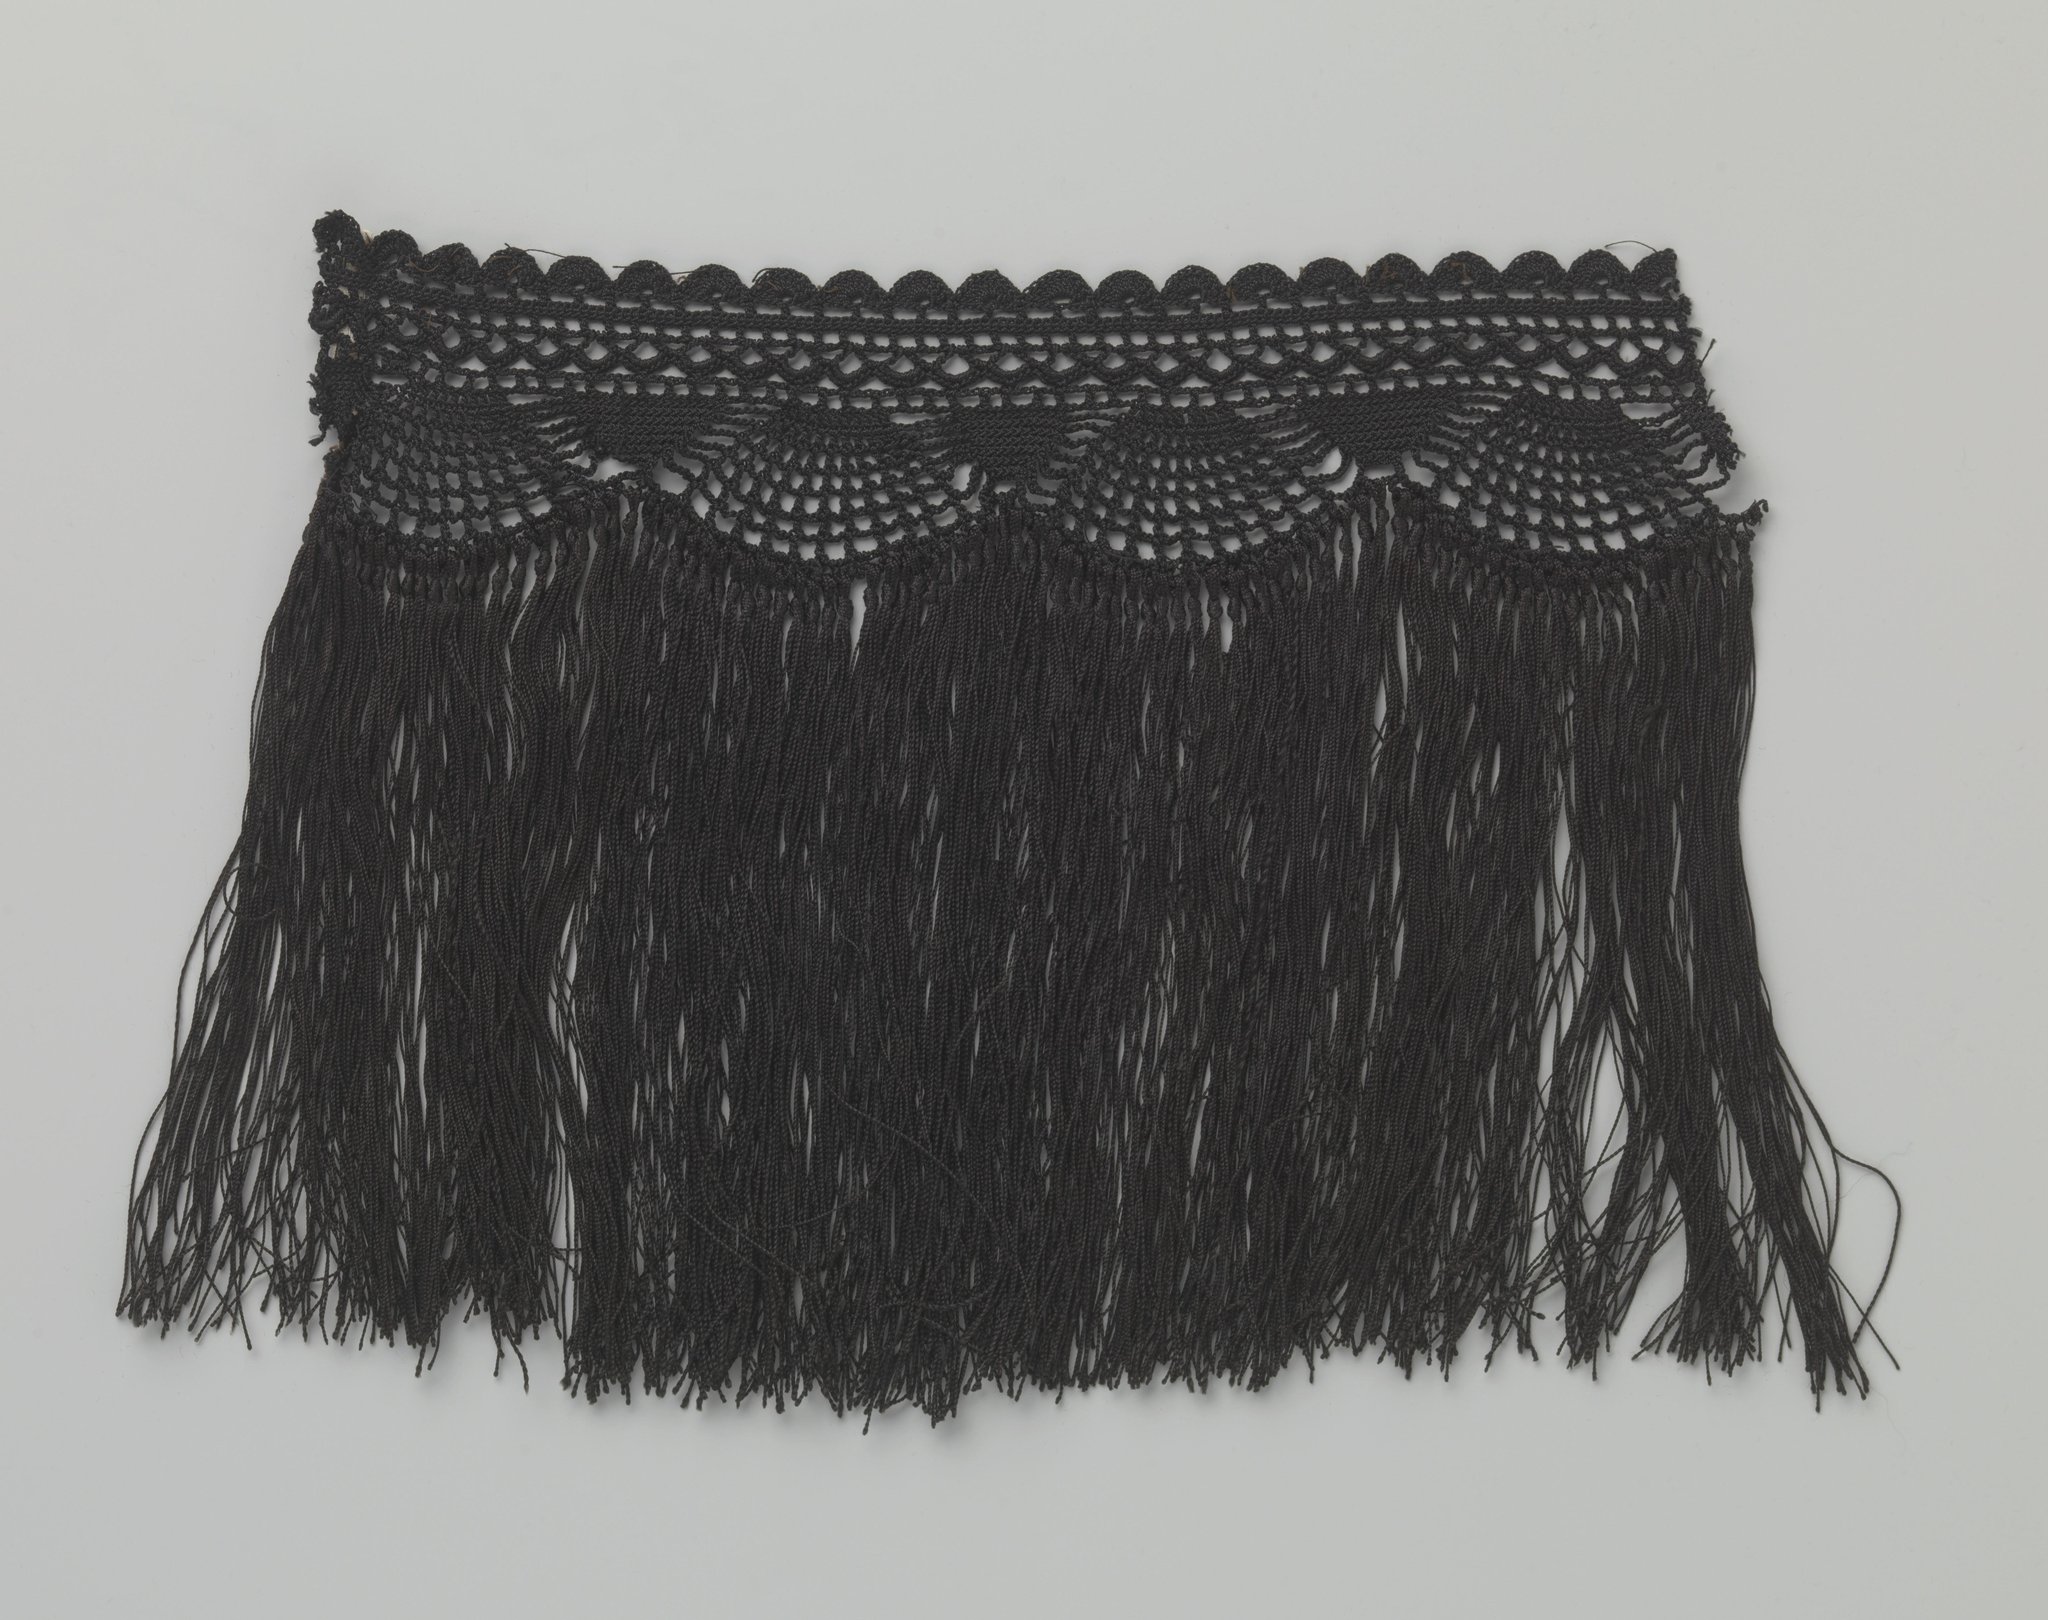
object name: strip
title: Strook zwarte gehaakte kant met franje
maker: Anonymous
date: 1850-1899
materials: cotton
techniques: crochet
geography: europe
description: Strook zwarte gehaakte kant met franje. Het haakwerk doet denken aan stropkant door de waaiervormige motieven.